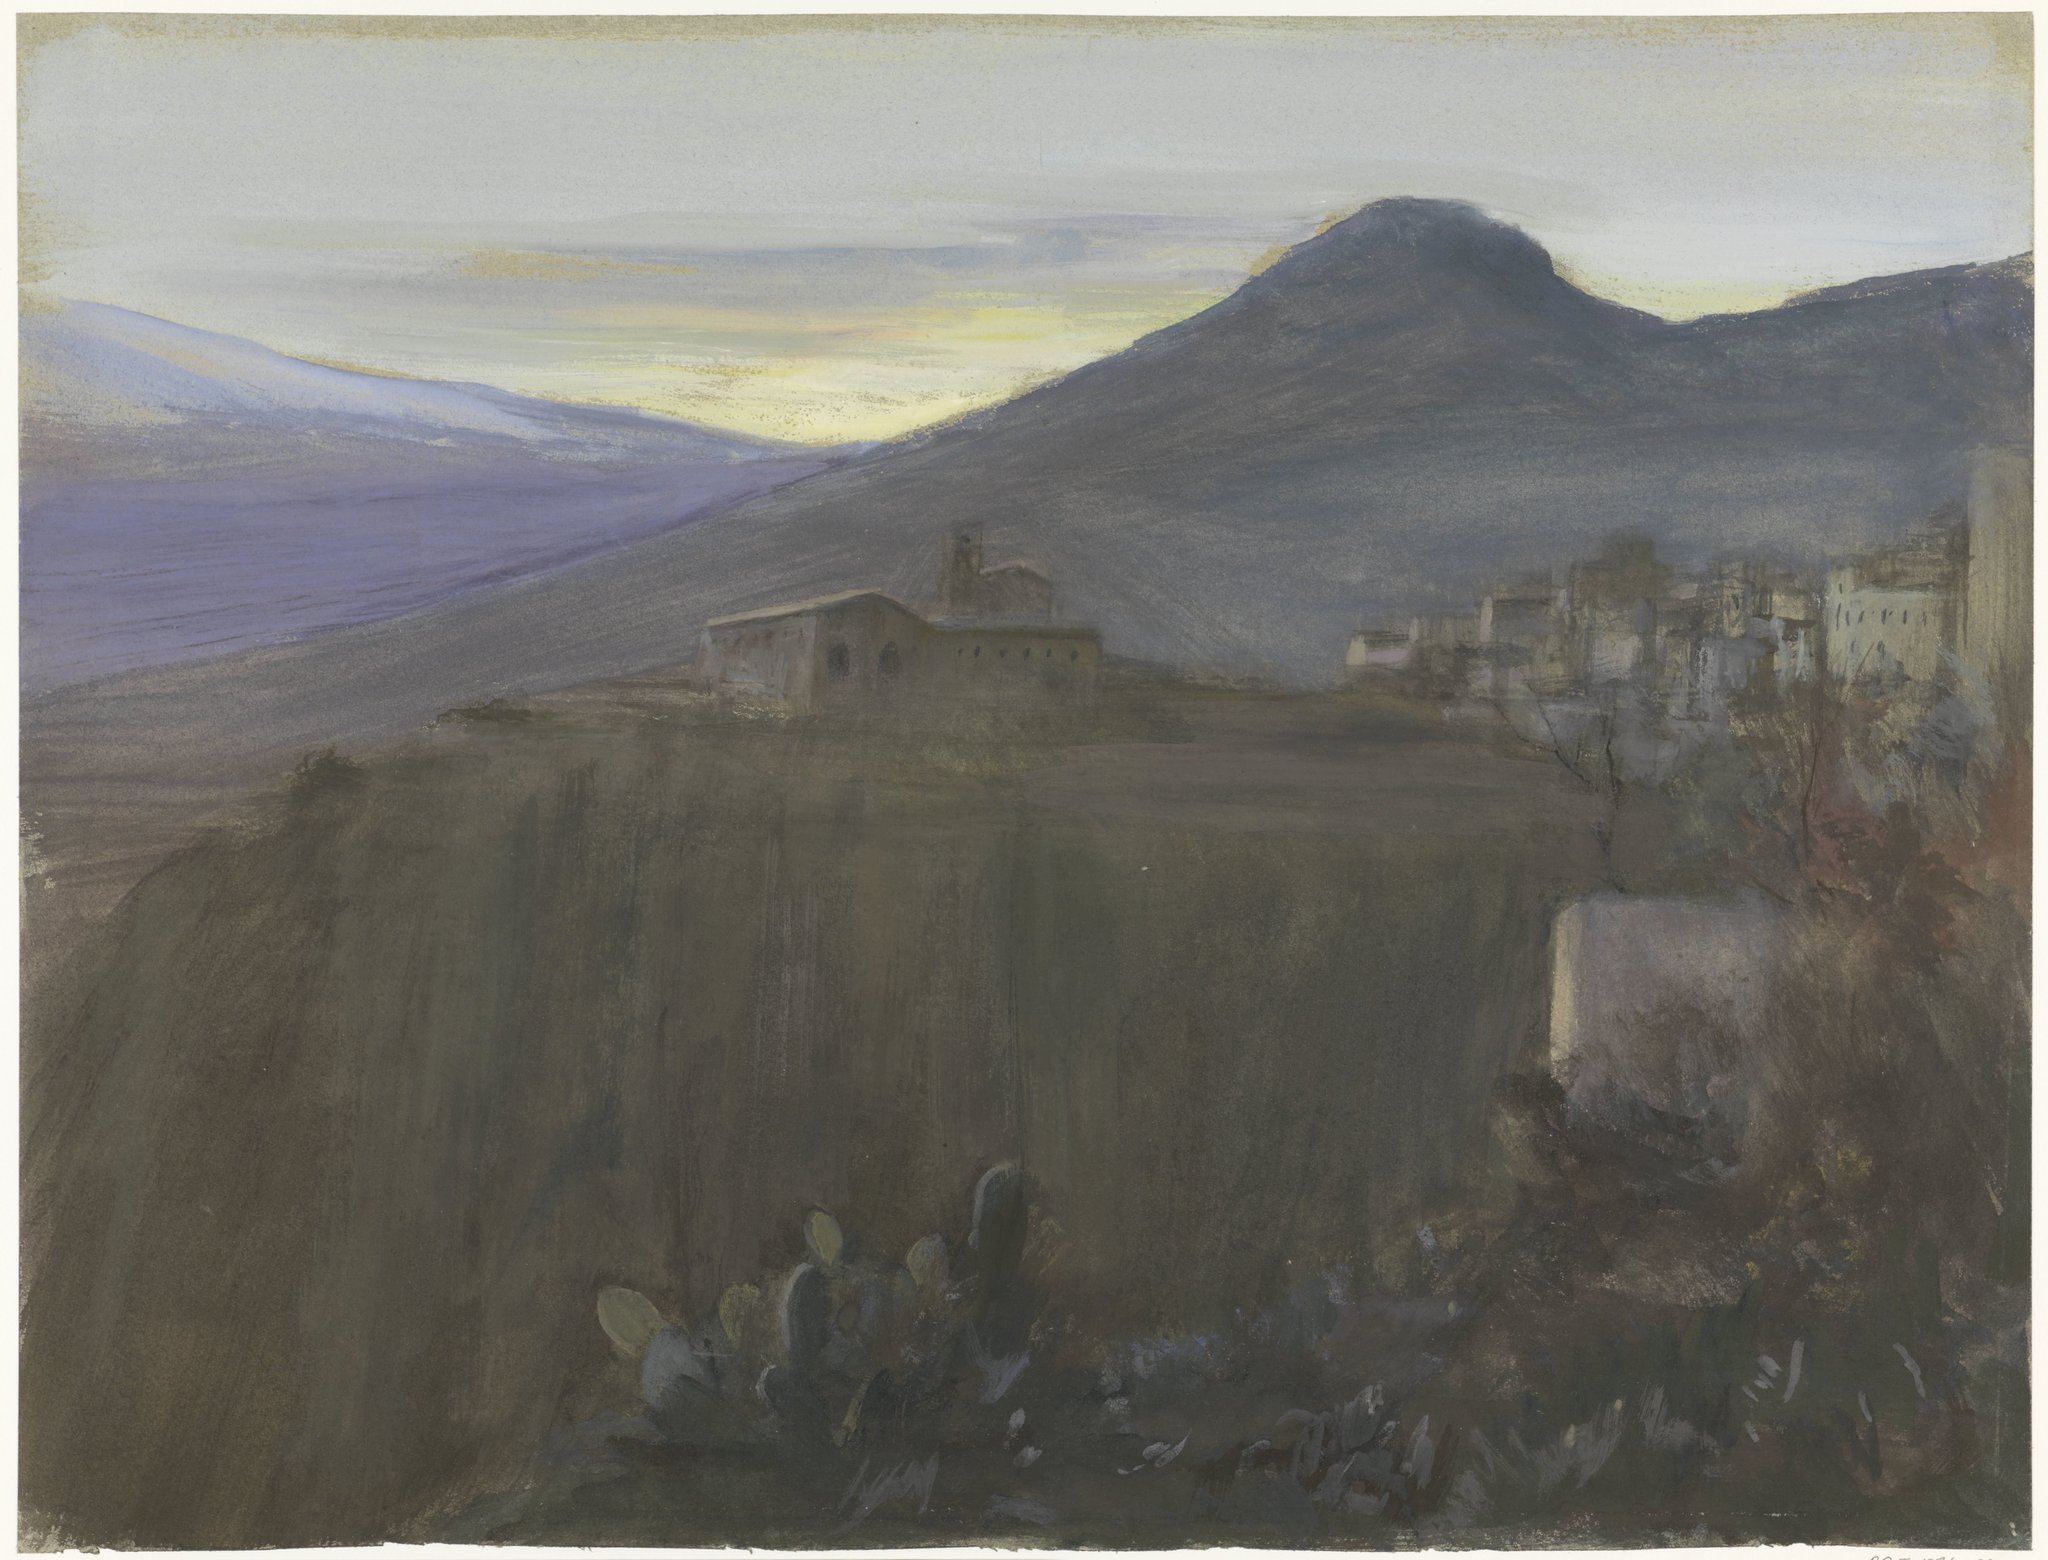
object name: drawing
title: Berglandschap te Taormina, Sicilië, Italië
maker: a.a.l. de grammont-hubrecht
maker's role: draughtsman, painter, print maker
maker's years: 1855-1913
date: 1865-1913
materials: chalk, paint, paper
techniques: brush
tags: mountains, italy